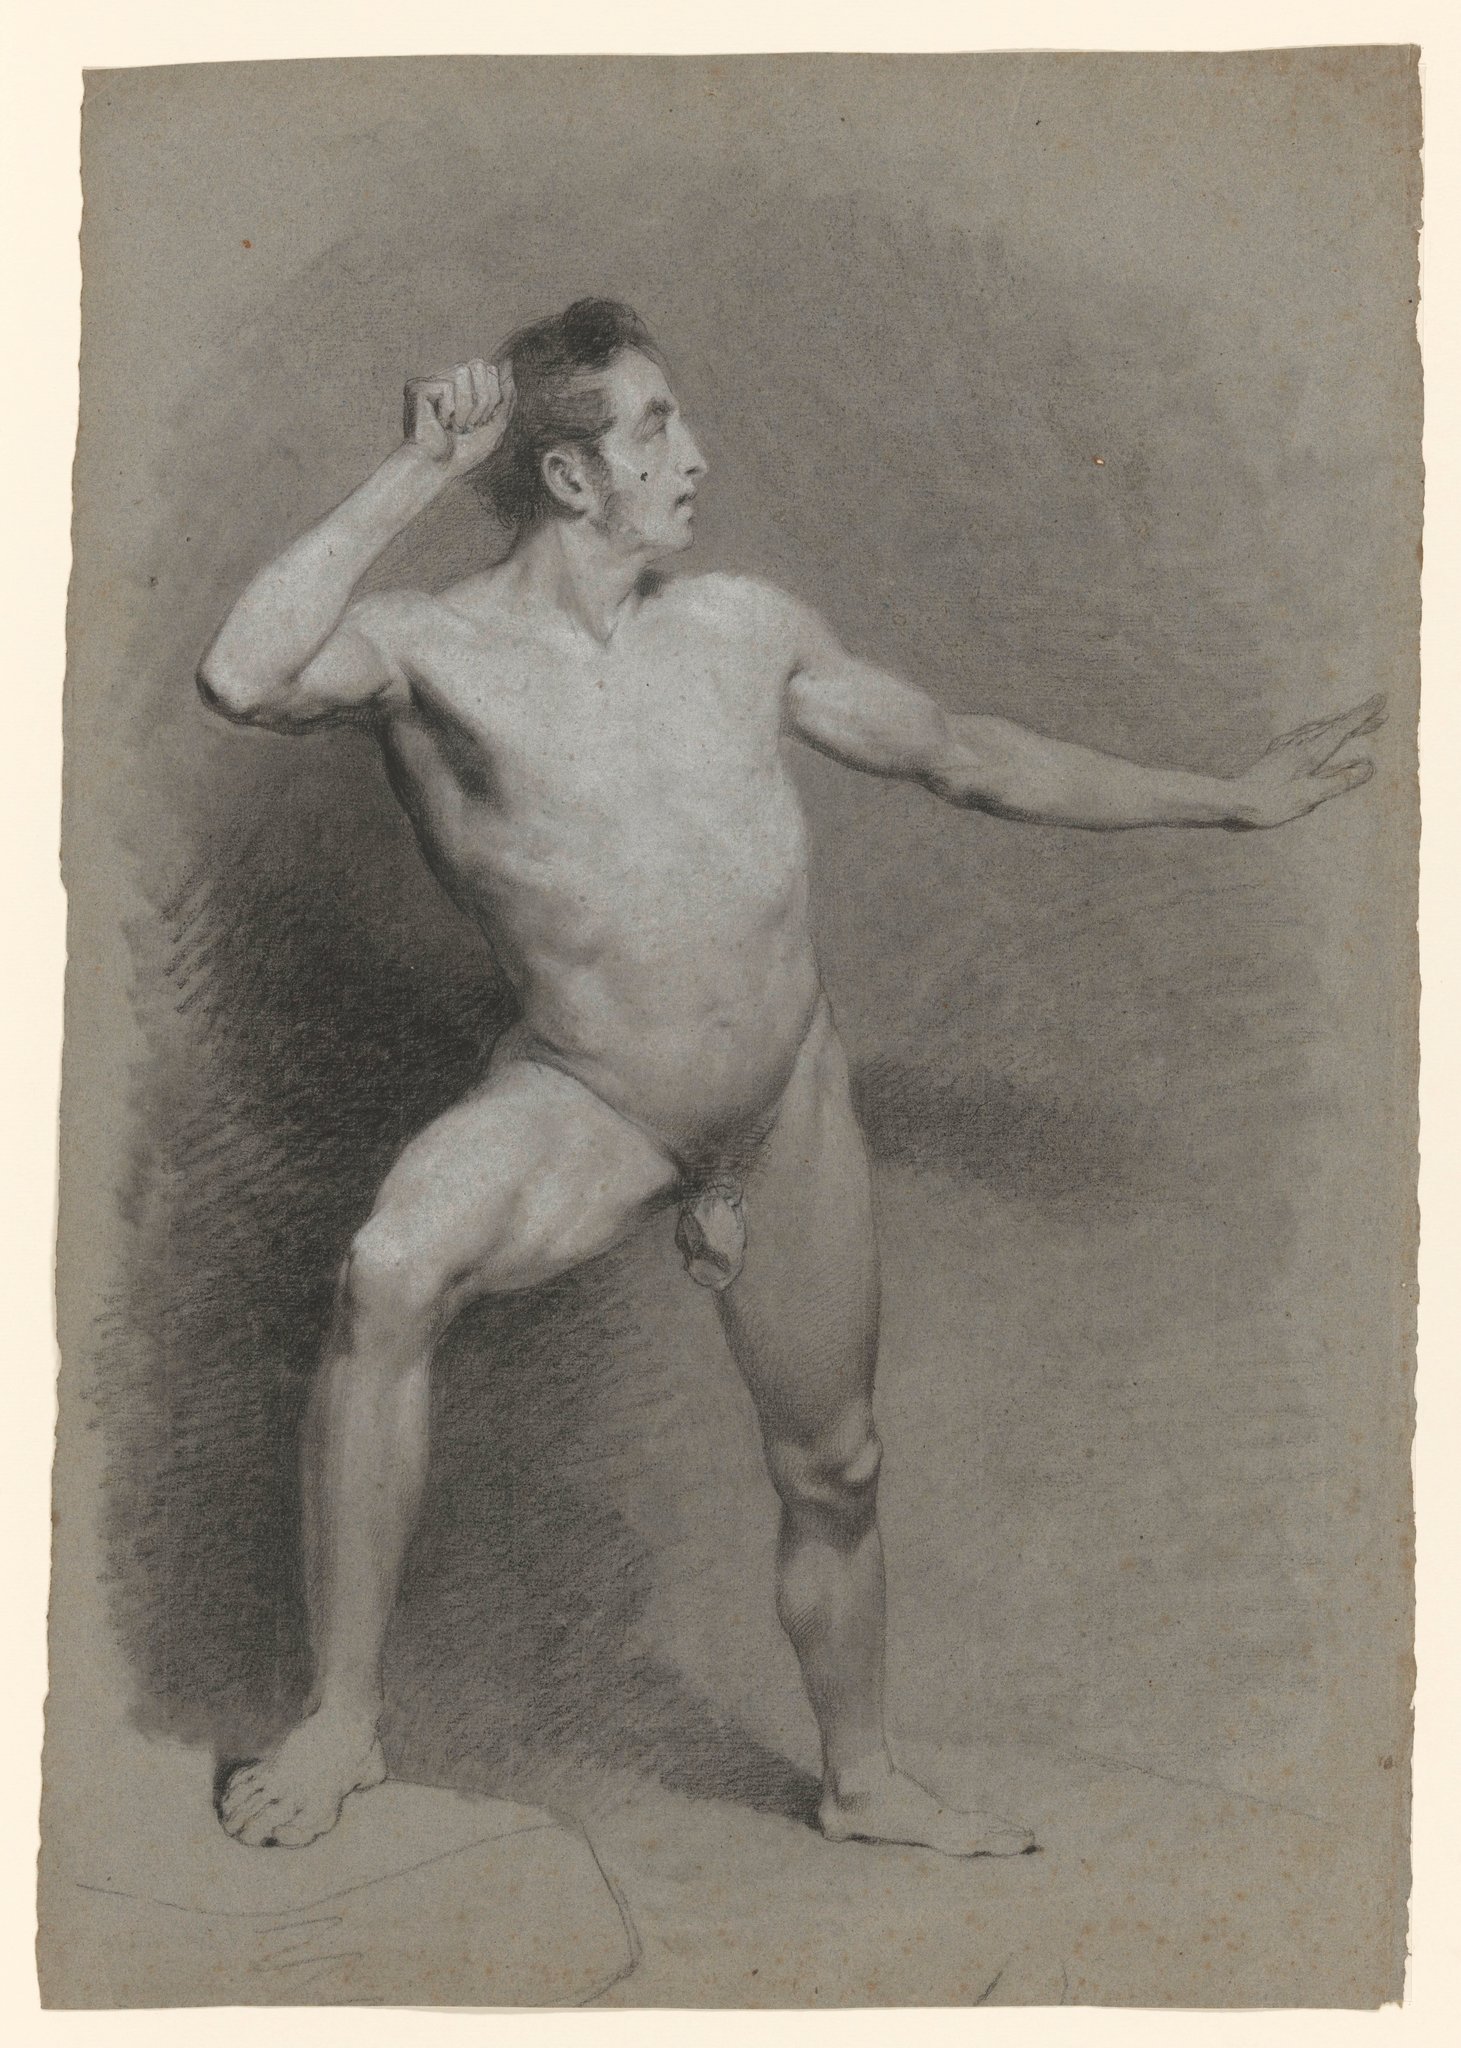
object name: drawing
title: Staand mannelijk naakt, naar rechts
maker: johannes tavenraat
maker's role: draughtsman, painter, print maker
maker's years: 1809-1881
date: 1819-1881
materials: chalk, paper